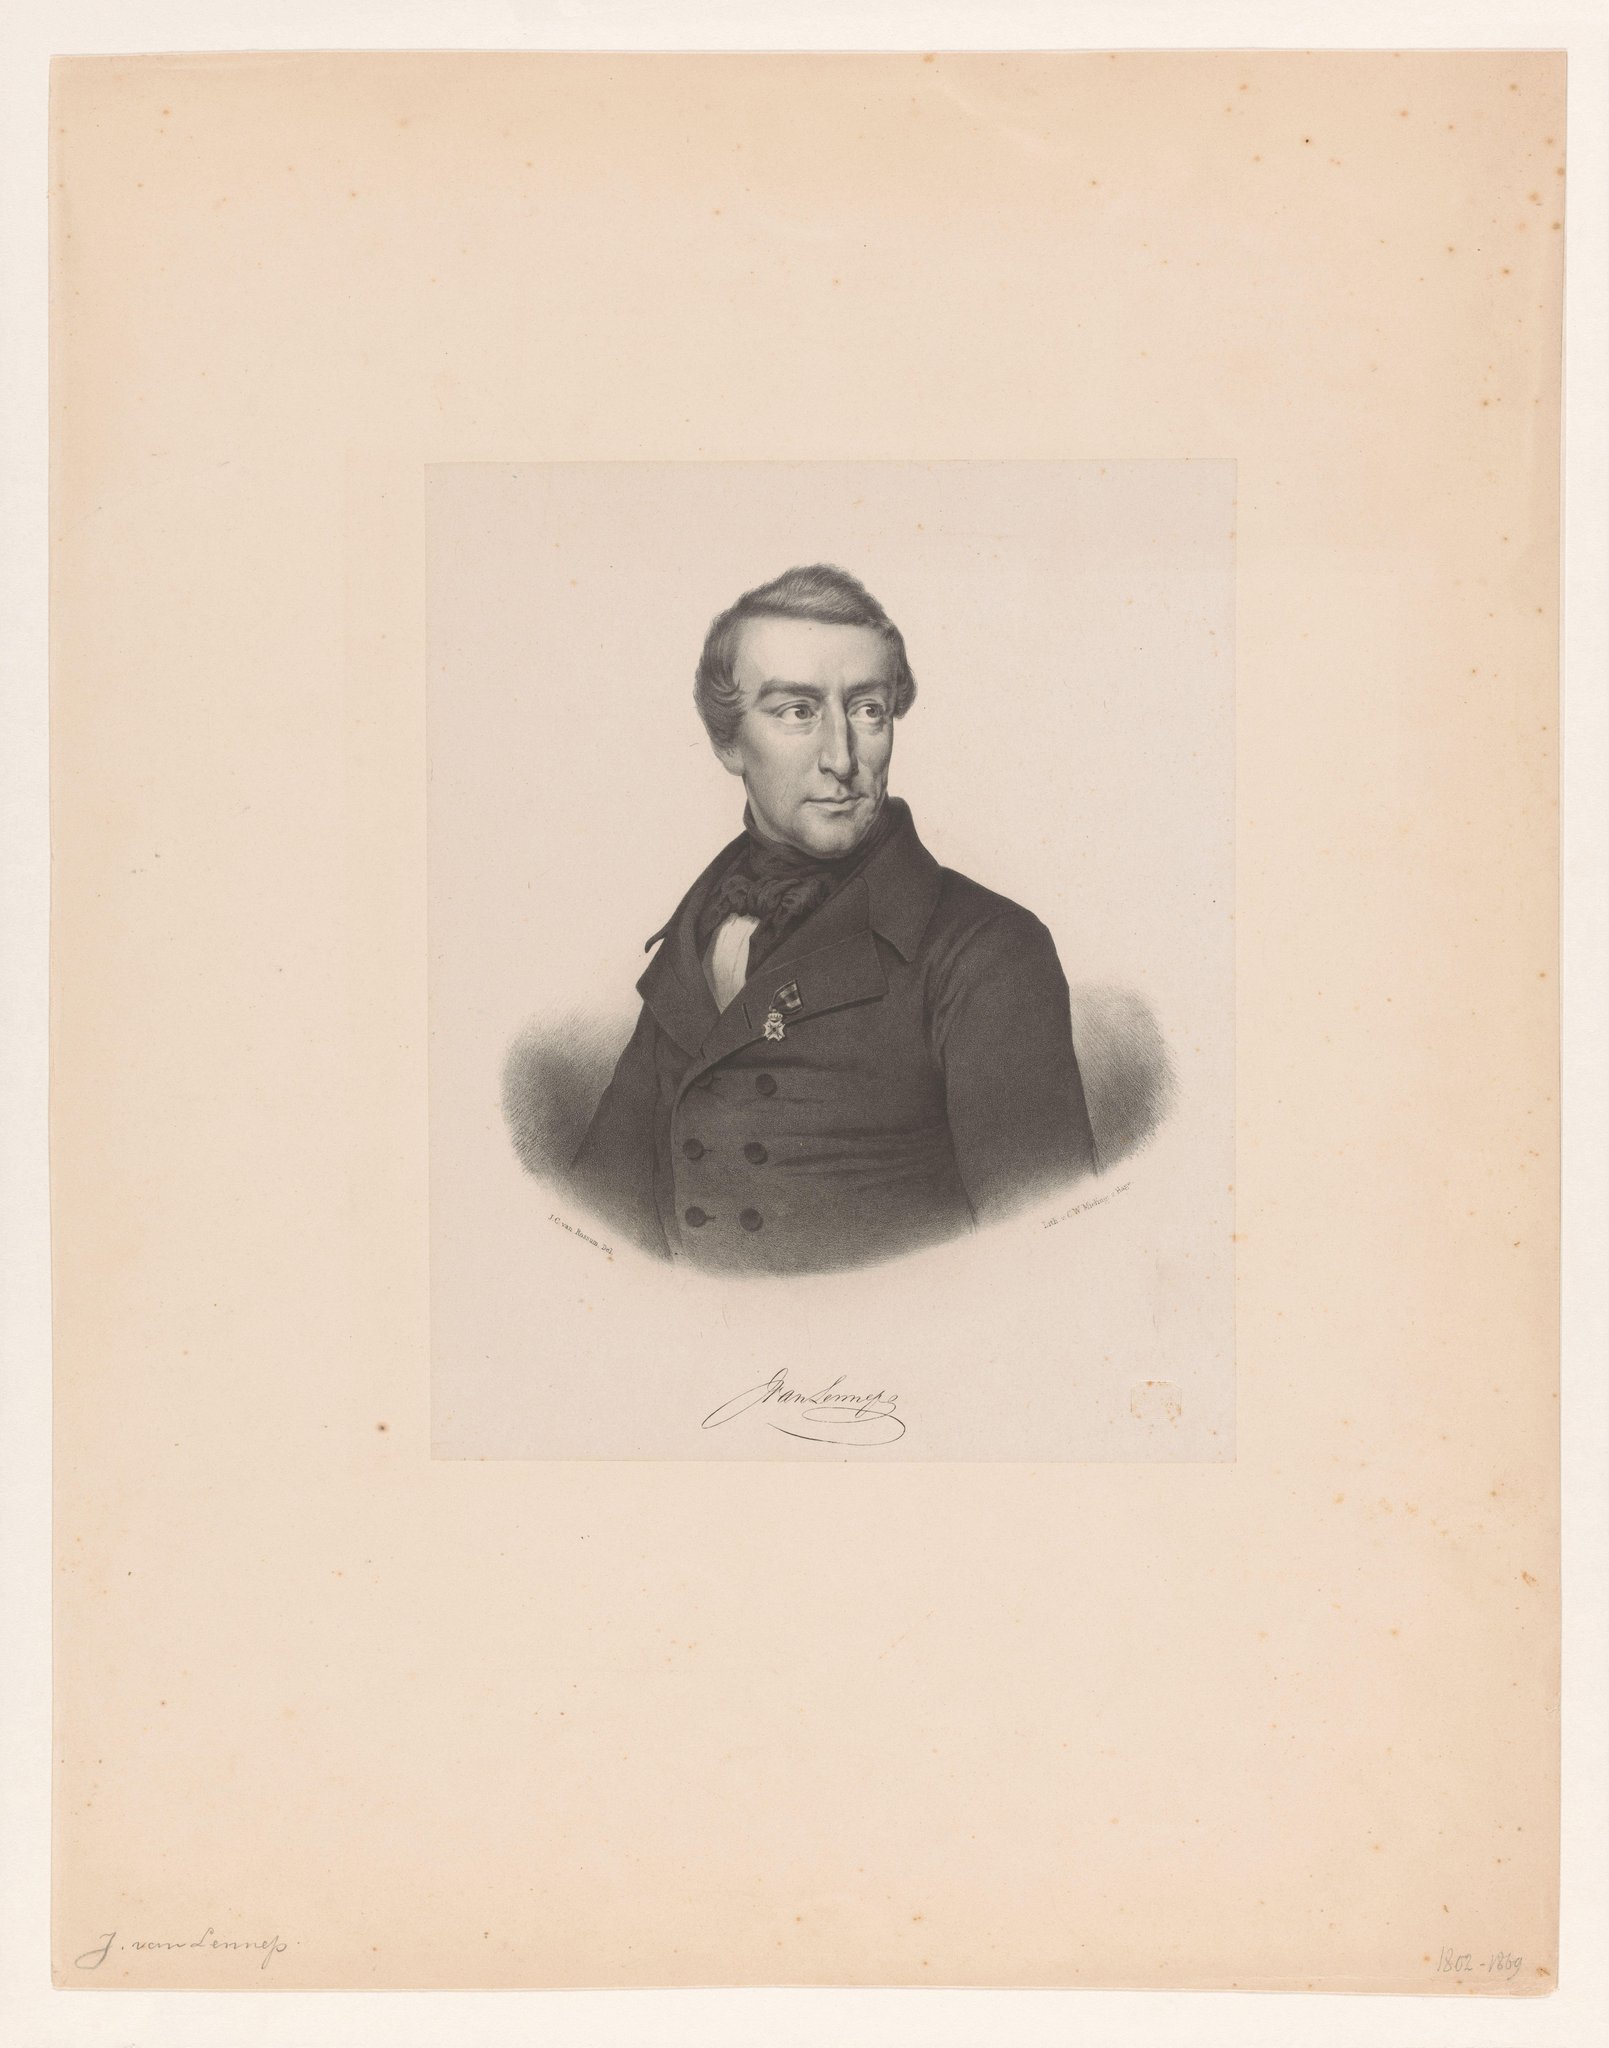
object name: print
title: Portret van Jacob van Lennep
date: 1845-1853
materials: paper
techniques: lithograph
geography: the hague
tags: amsterdam, jacob van lennep, historical persons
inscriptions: check stamp: ‘J.C.v.R.’, collector's mark: Lugt 2228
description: Onder het portret de signatuur van de geportretteerde.